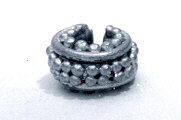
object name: nose ornament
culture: calima or yotoco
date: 1-700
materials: gold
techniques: casting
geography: colombia